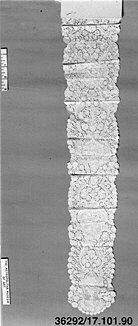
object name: lappet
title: Joined lappet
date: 1701-1733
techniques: lace